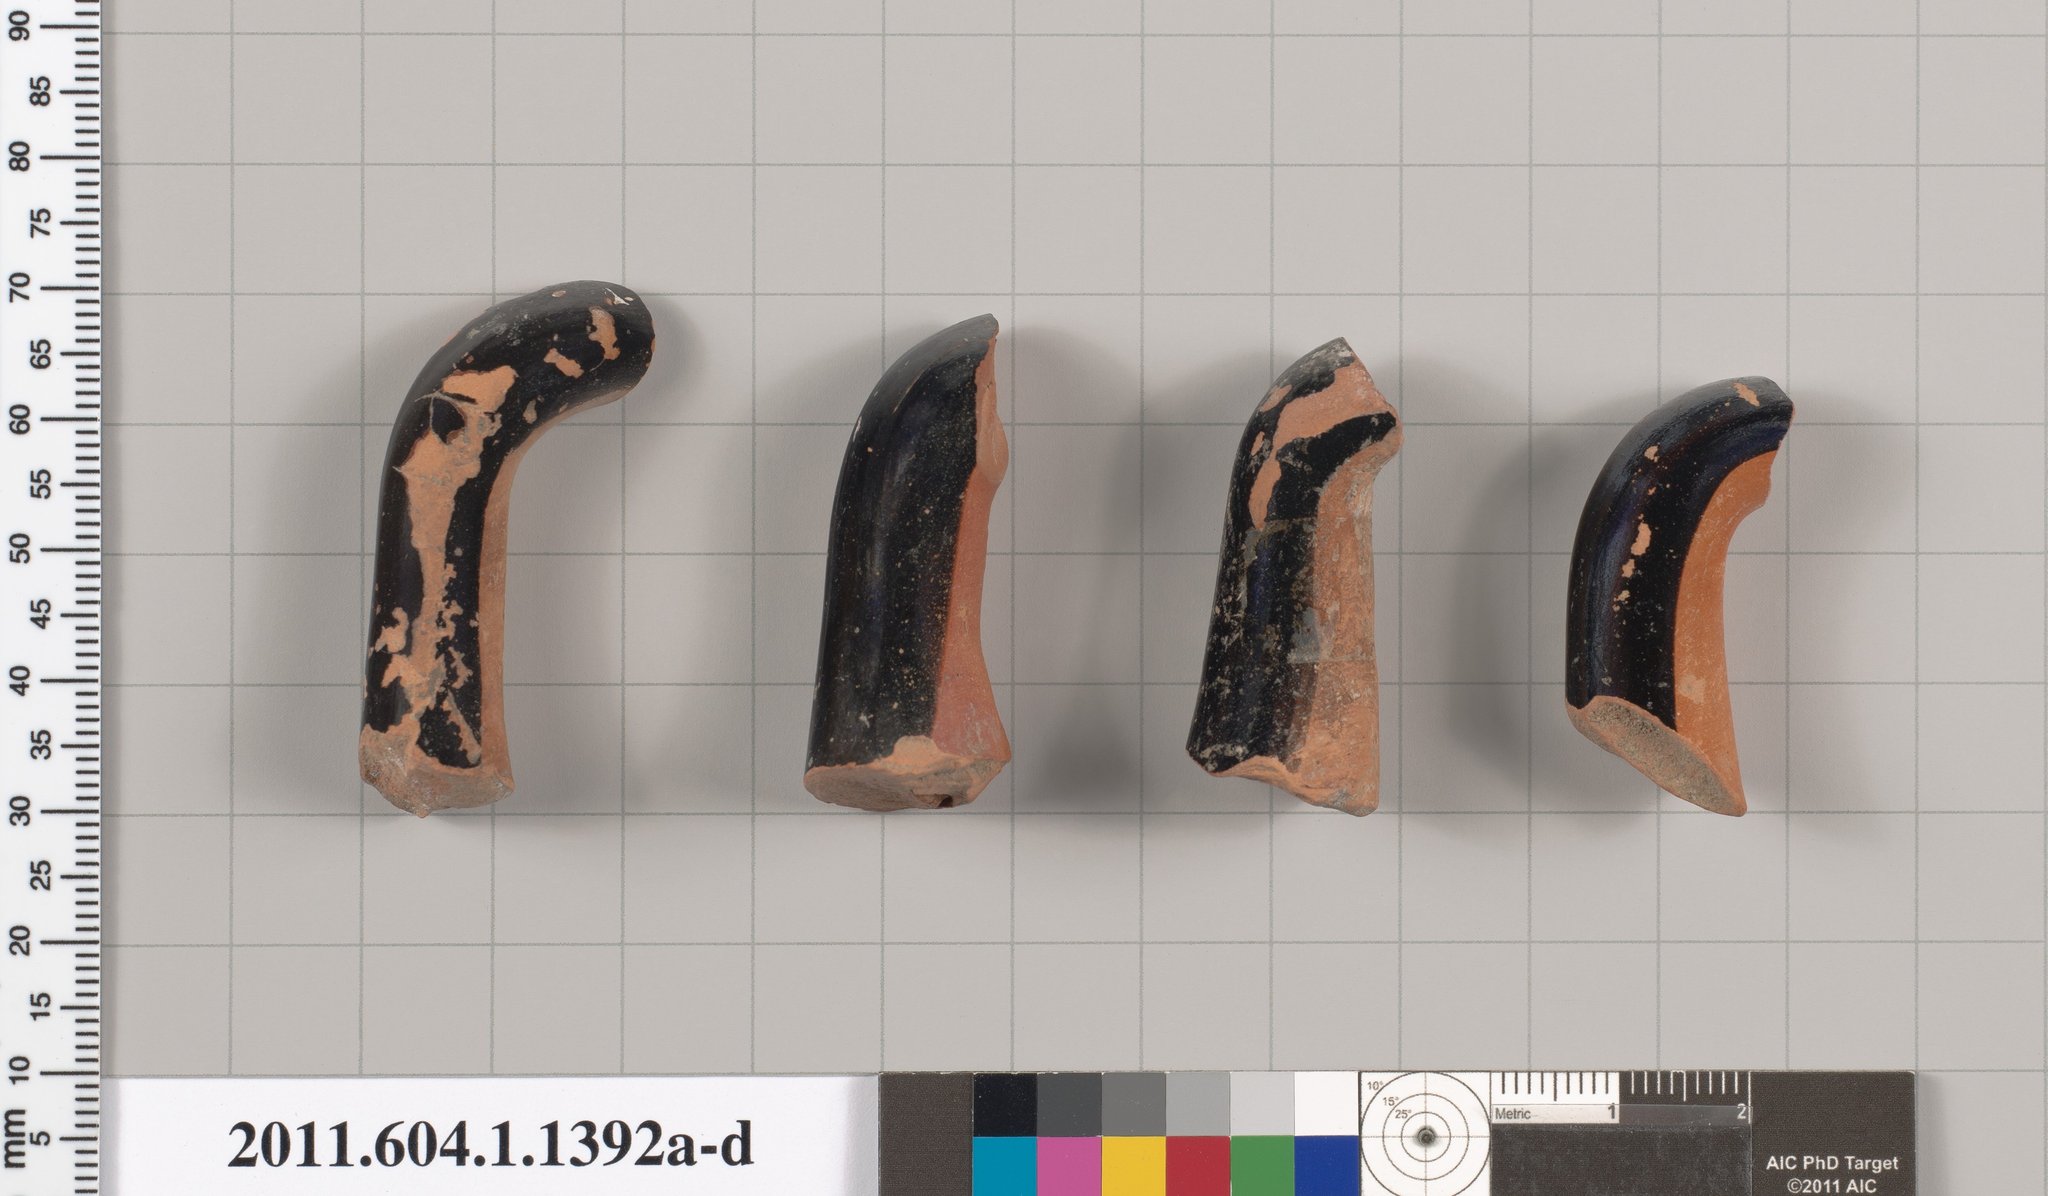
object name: kylix fragment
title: Terracotta fragments of kylikes (drinking cups)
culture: greek, attic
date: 500-401 BCE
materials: terracotta